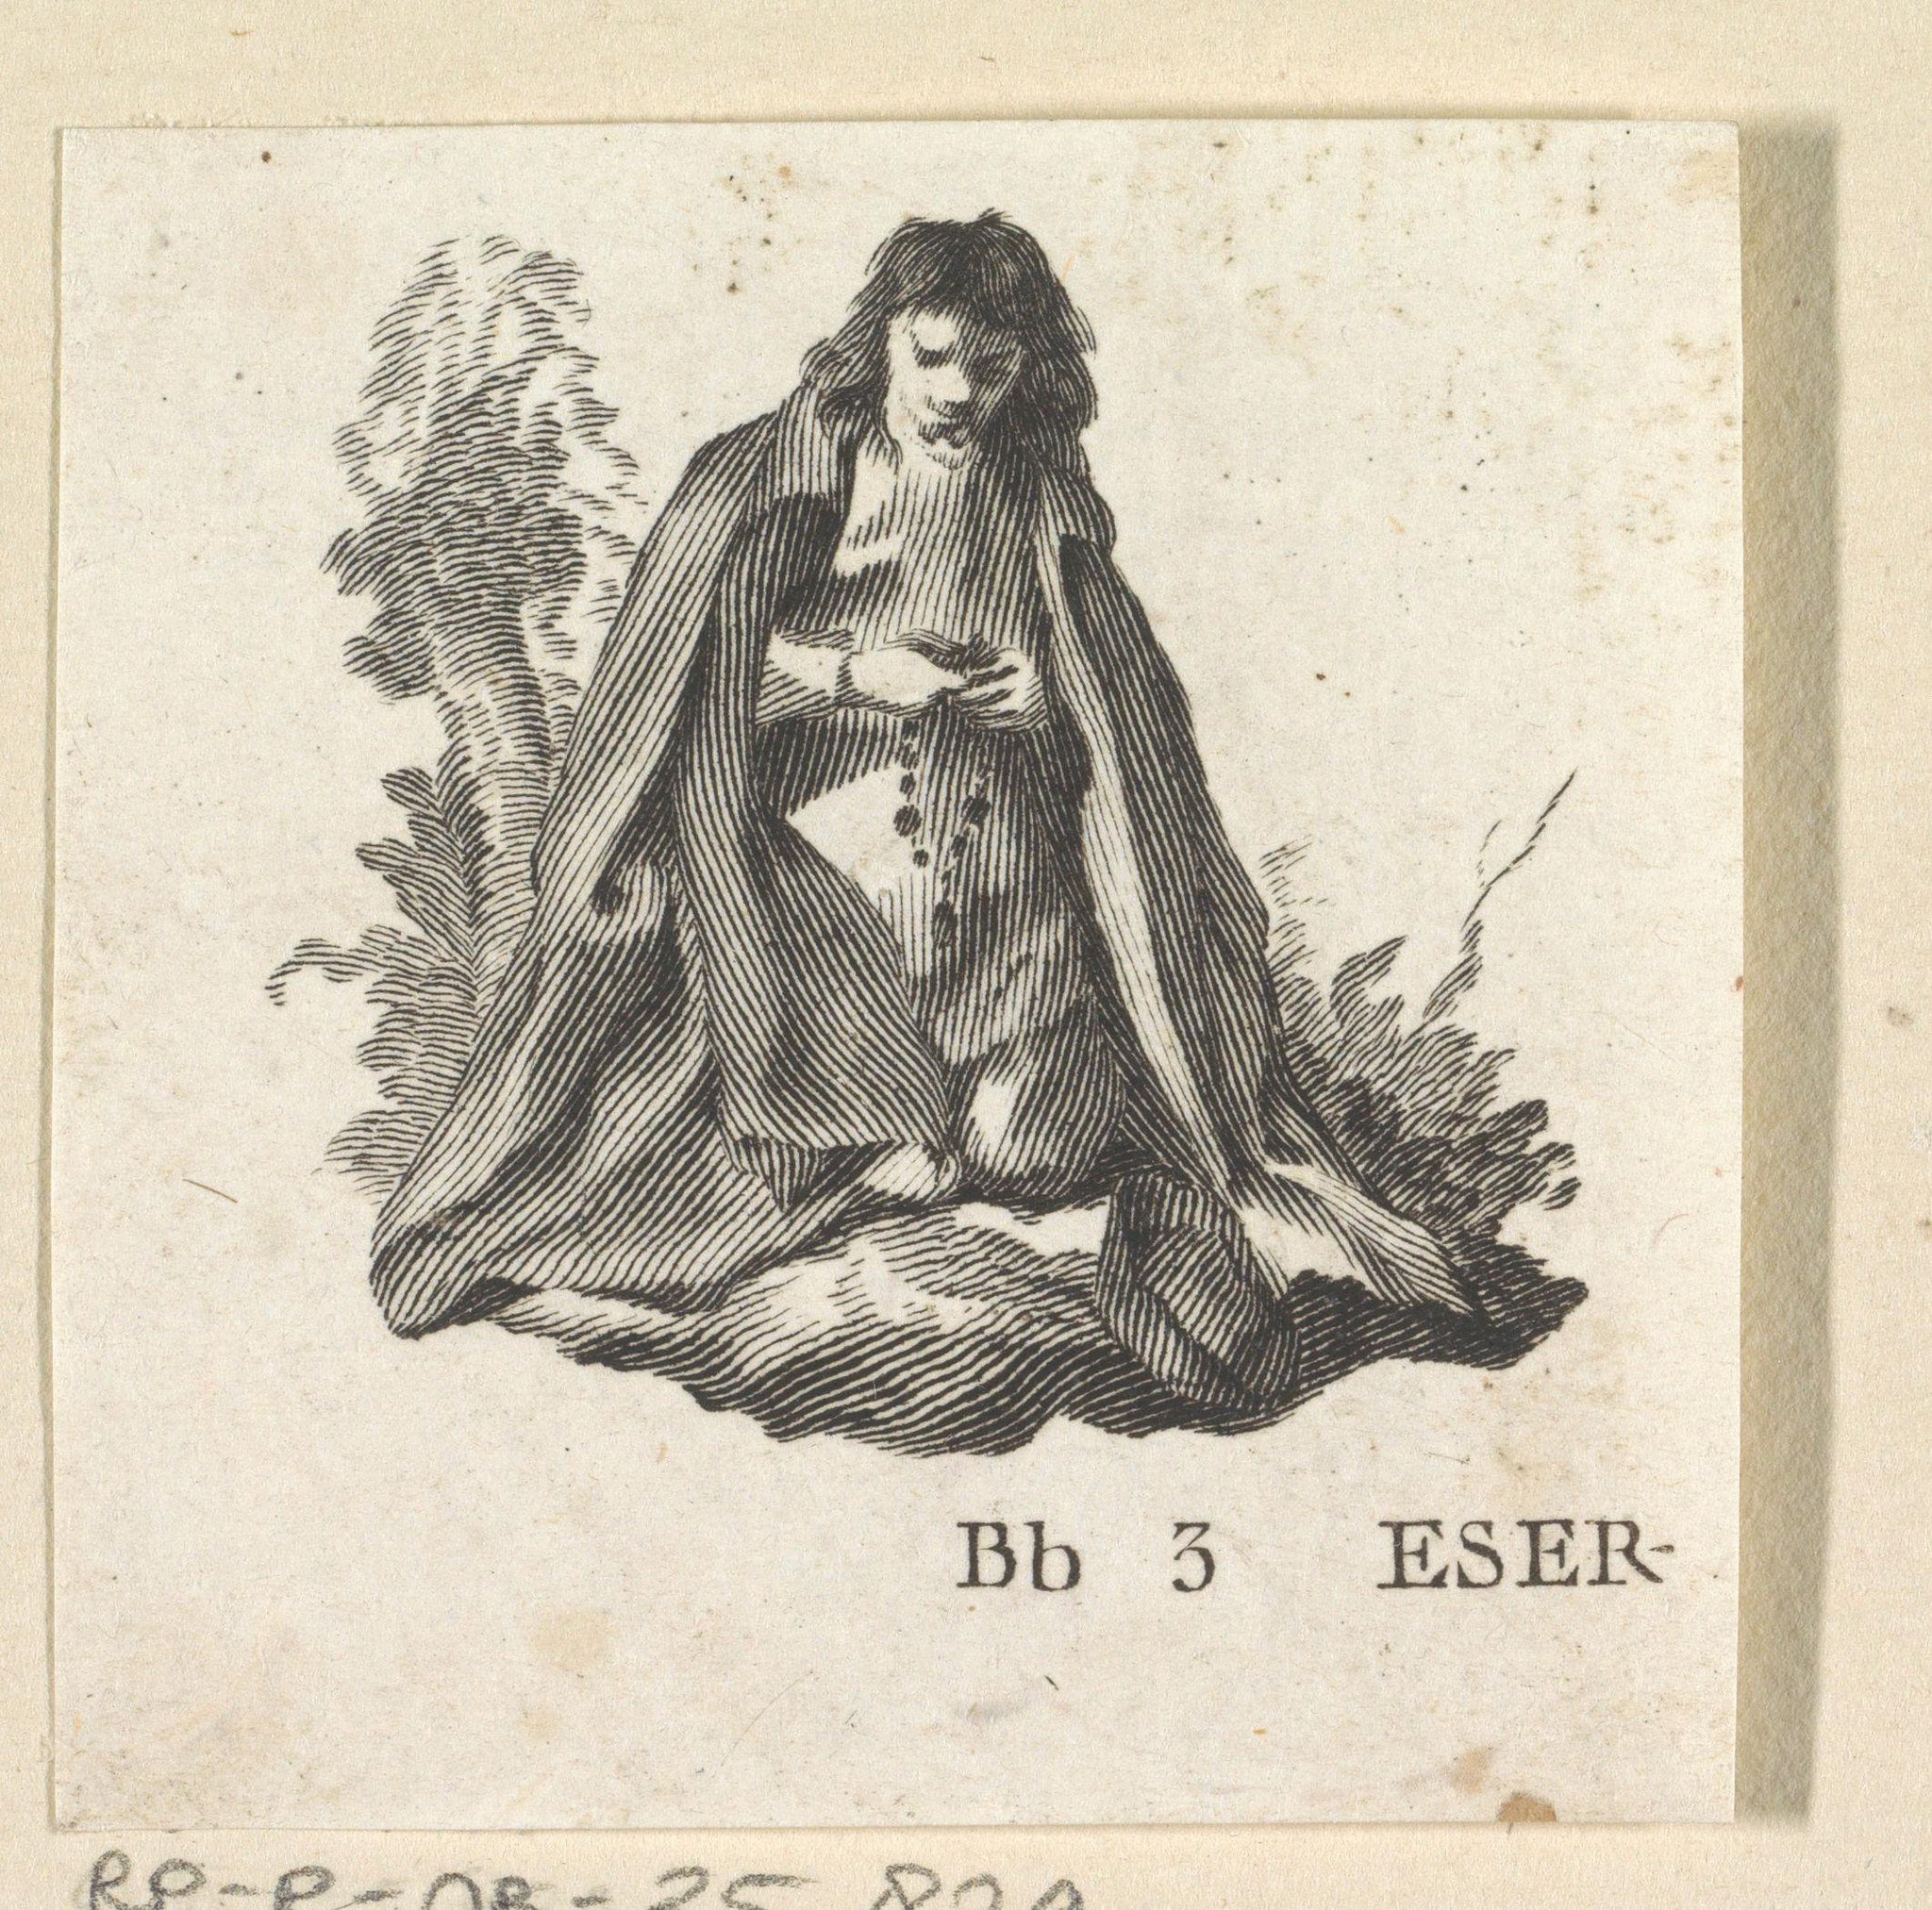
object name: print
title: Knielende man in gebed met rozenkrans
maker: giovanni cattini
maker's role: print maker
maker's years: 1725-1800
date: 1735-1800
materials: paper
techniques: engraving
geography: italy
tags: aids for prayer, e.g. rosary, saying the rosary, one person praying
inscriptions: collector's mark: Lugt 240